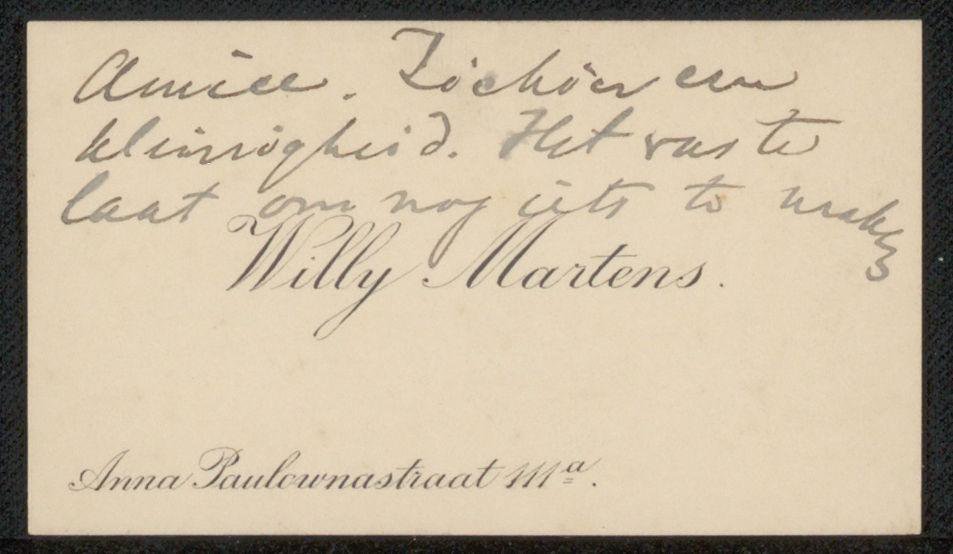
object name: visiting card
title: Visitekaartje aan Philip Zilcken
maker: willy martens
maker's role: painter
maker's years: 1856-1927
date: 1867-1927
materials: cardboard, pencil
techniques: printing, writing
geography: the hague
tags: the hague, painter, draughtsman, philip zilcken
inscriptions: collector's mark: ‘RPK’